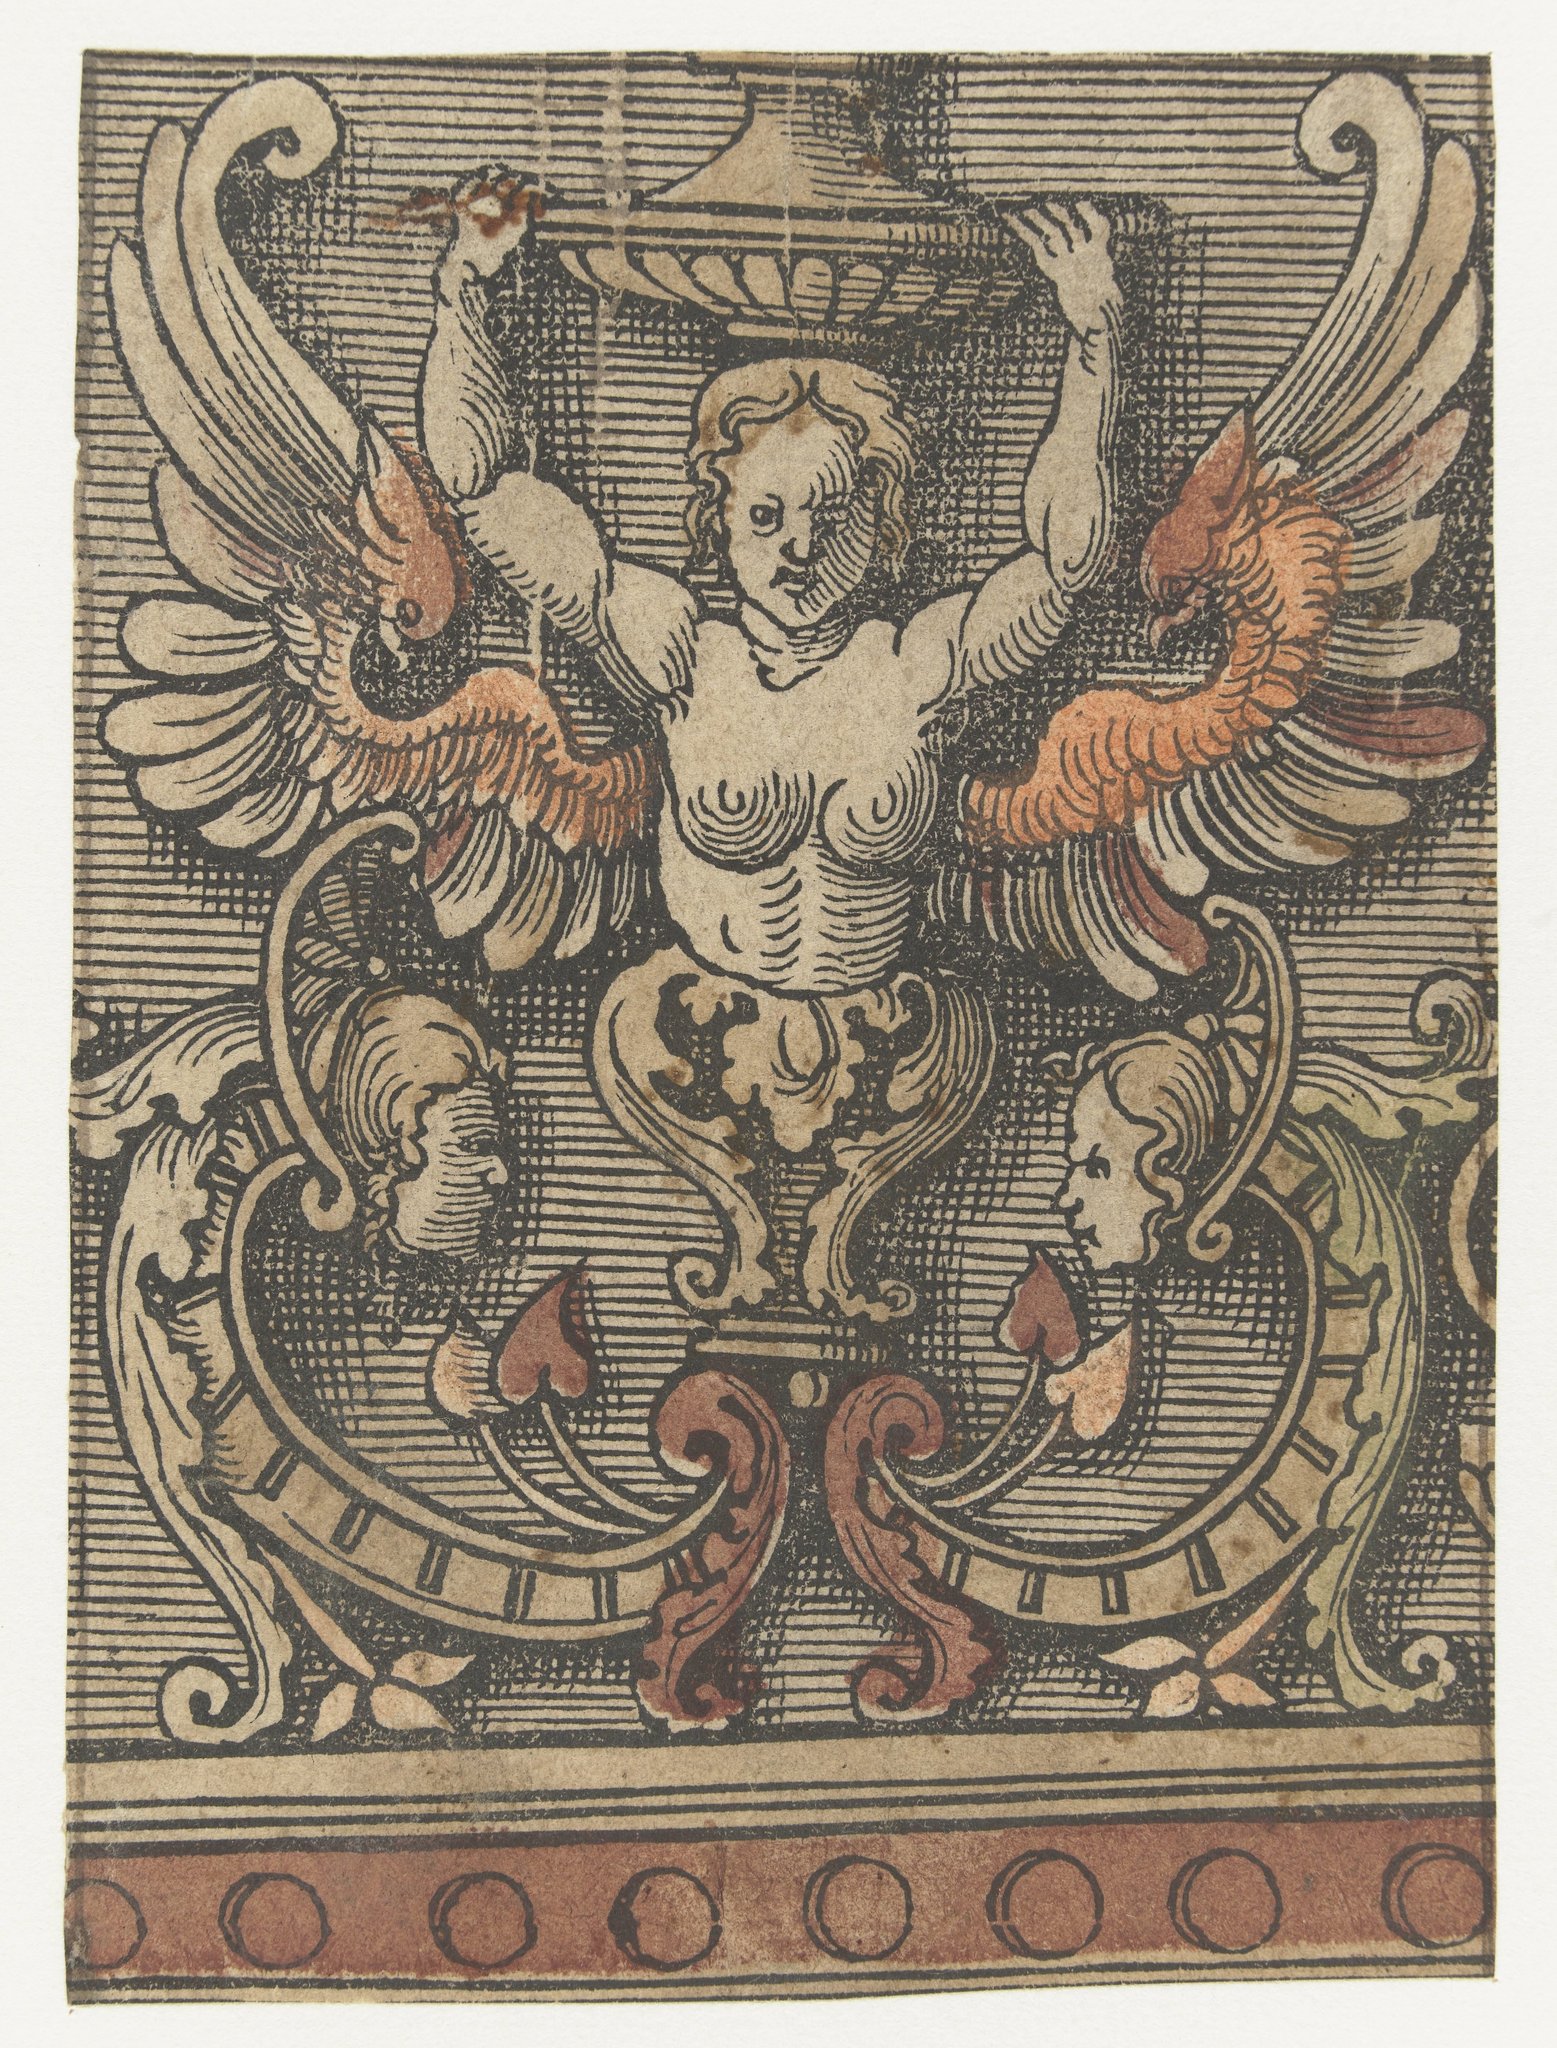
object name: ornament print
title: Ornament met gevleugelde vrouw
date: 1504-1533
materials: paper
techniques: hand coloring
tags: ornament ~ hybrid beings; human and animal forms mixed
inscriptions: collector's mark: Lugt 2228a, collector's mark: Lugt 240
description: Fragment van lijst met ornamentele decoratie.